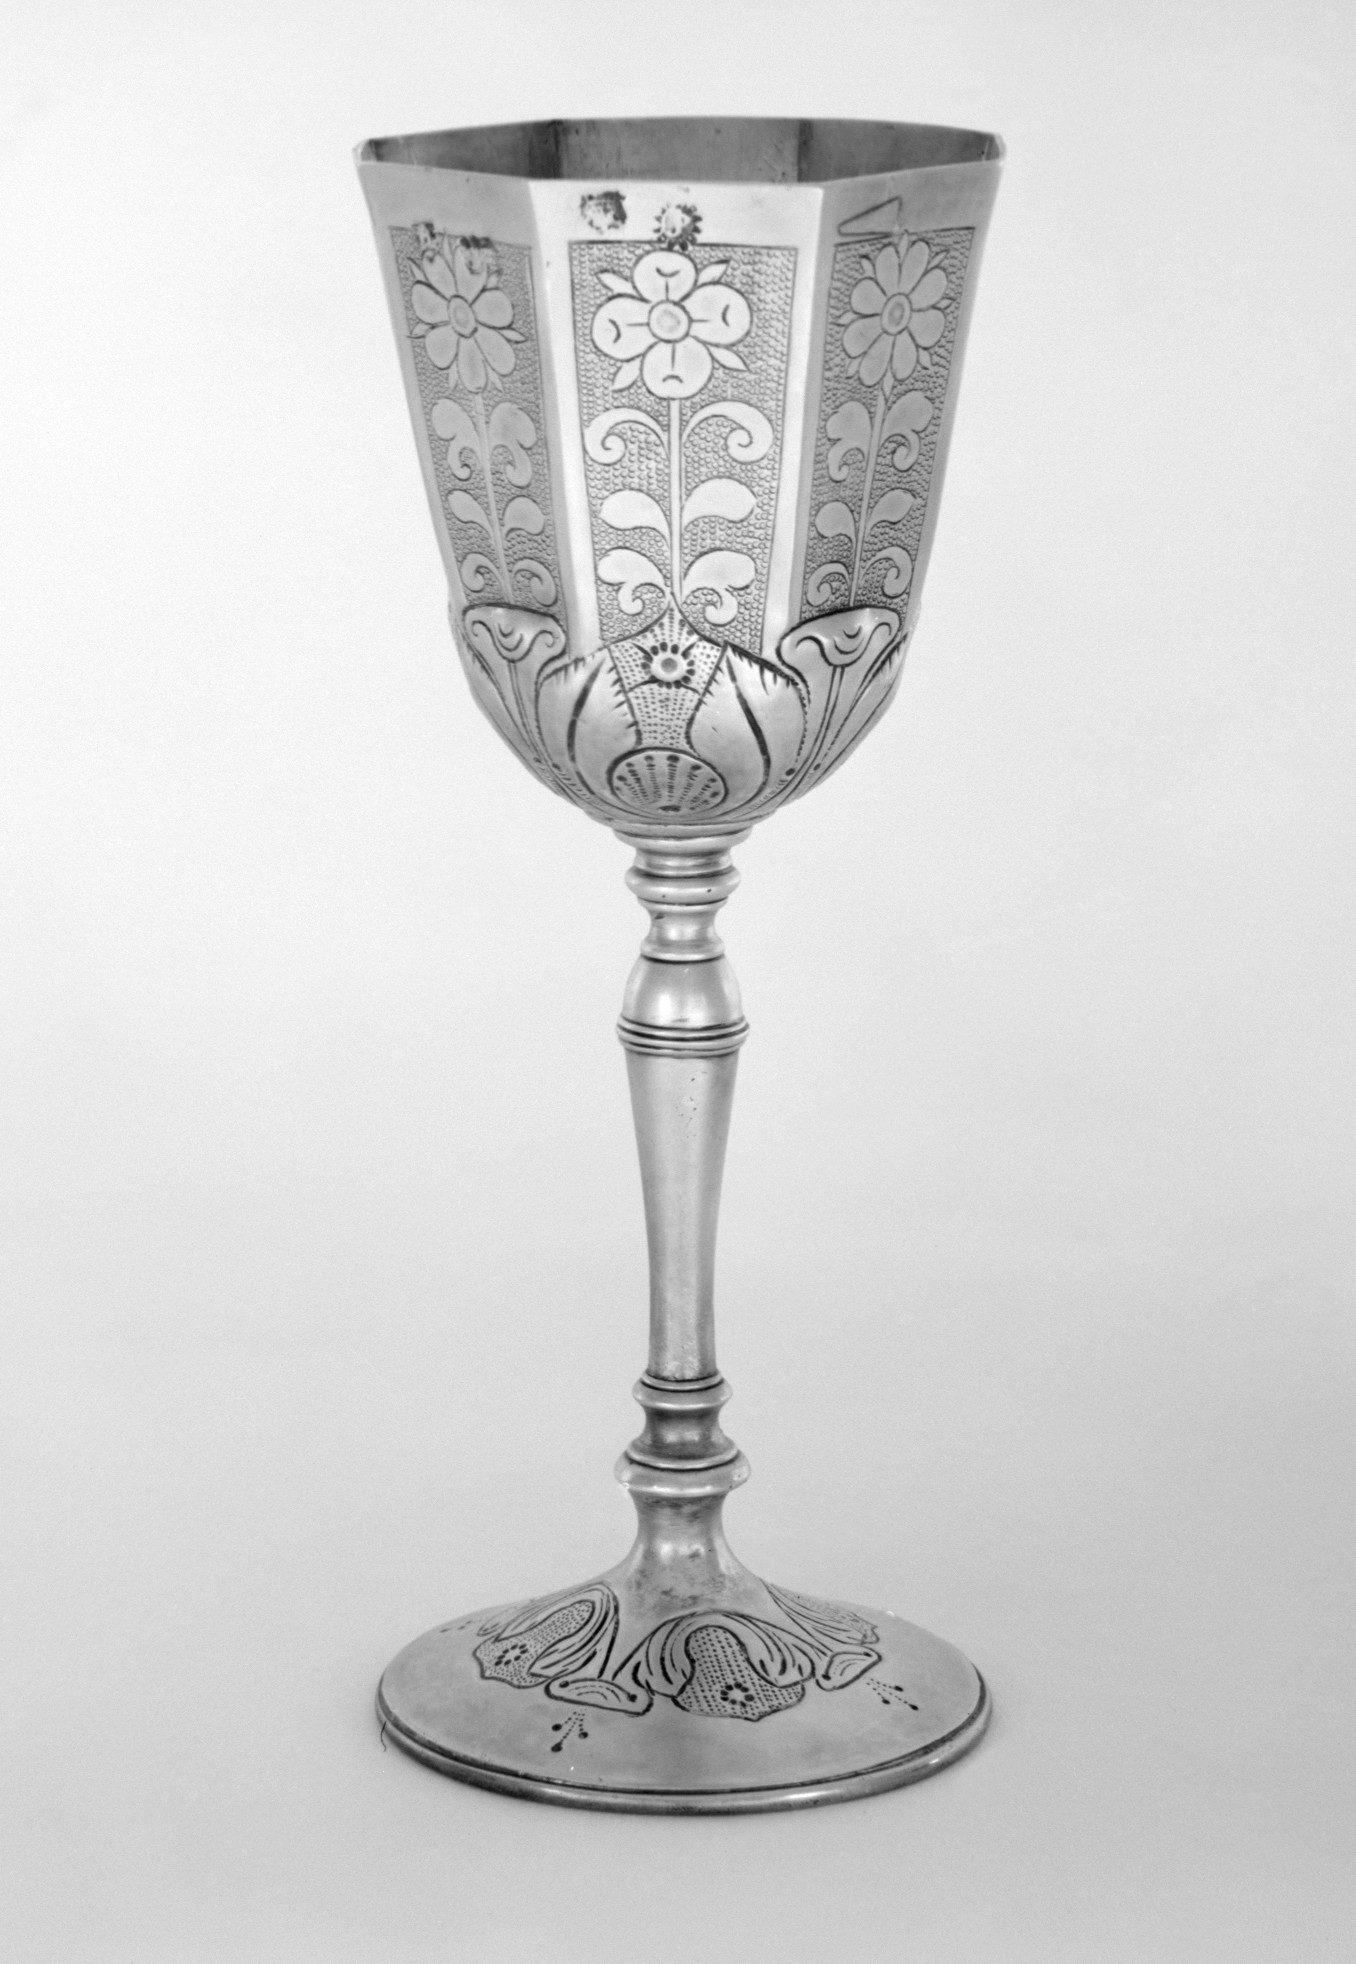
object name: wine cup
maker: jeffery prescott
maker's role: maker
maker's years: 1575-1675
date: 1618-1619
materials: silver gilt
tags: flowers